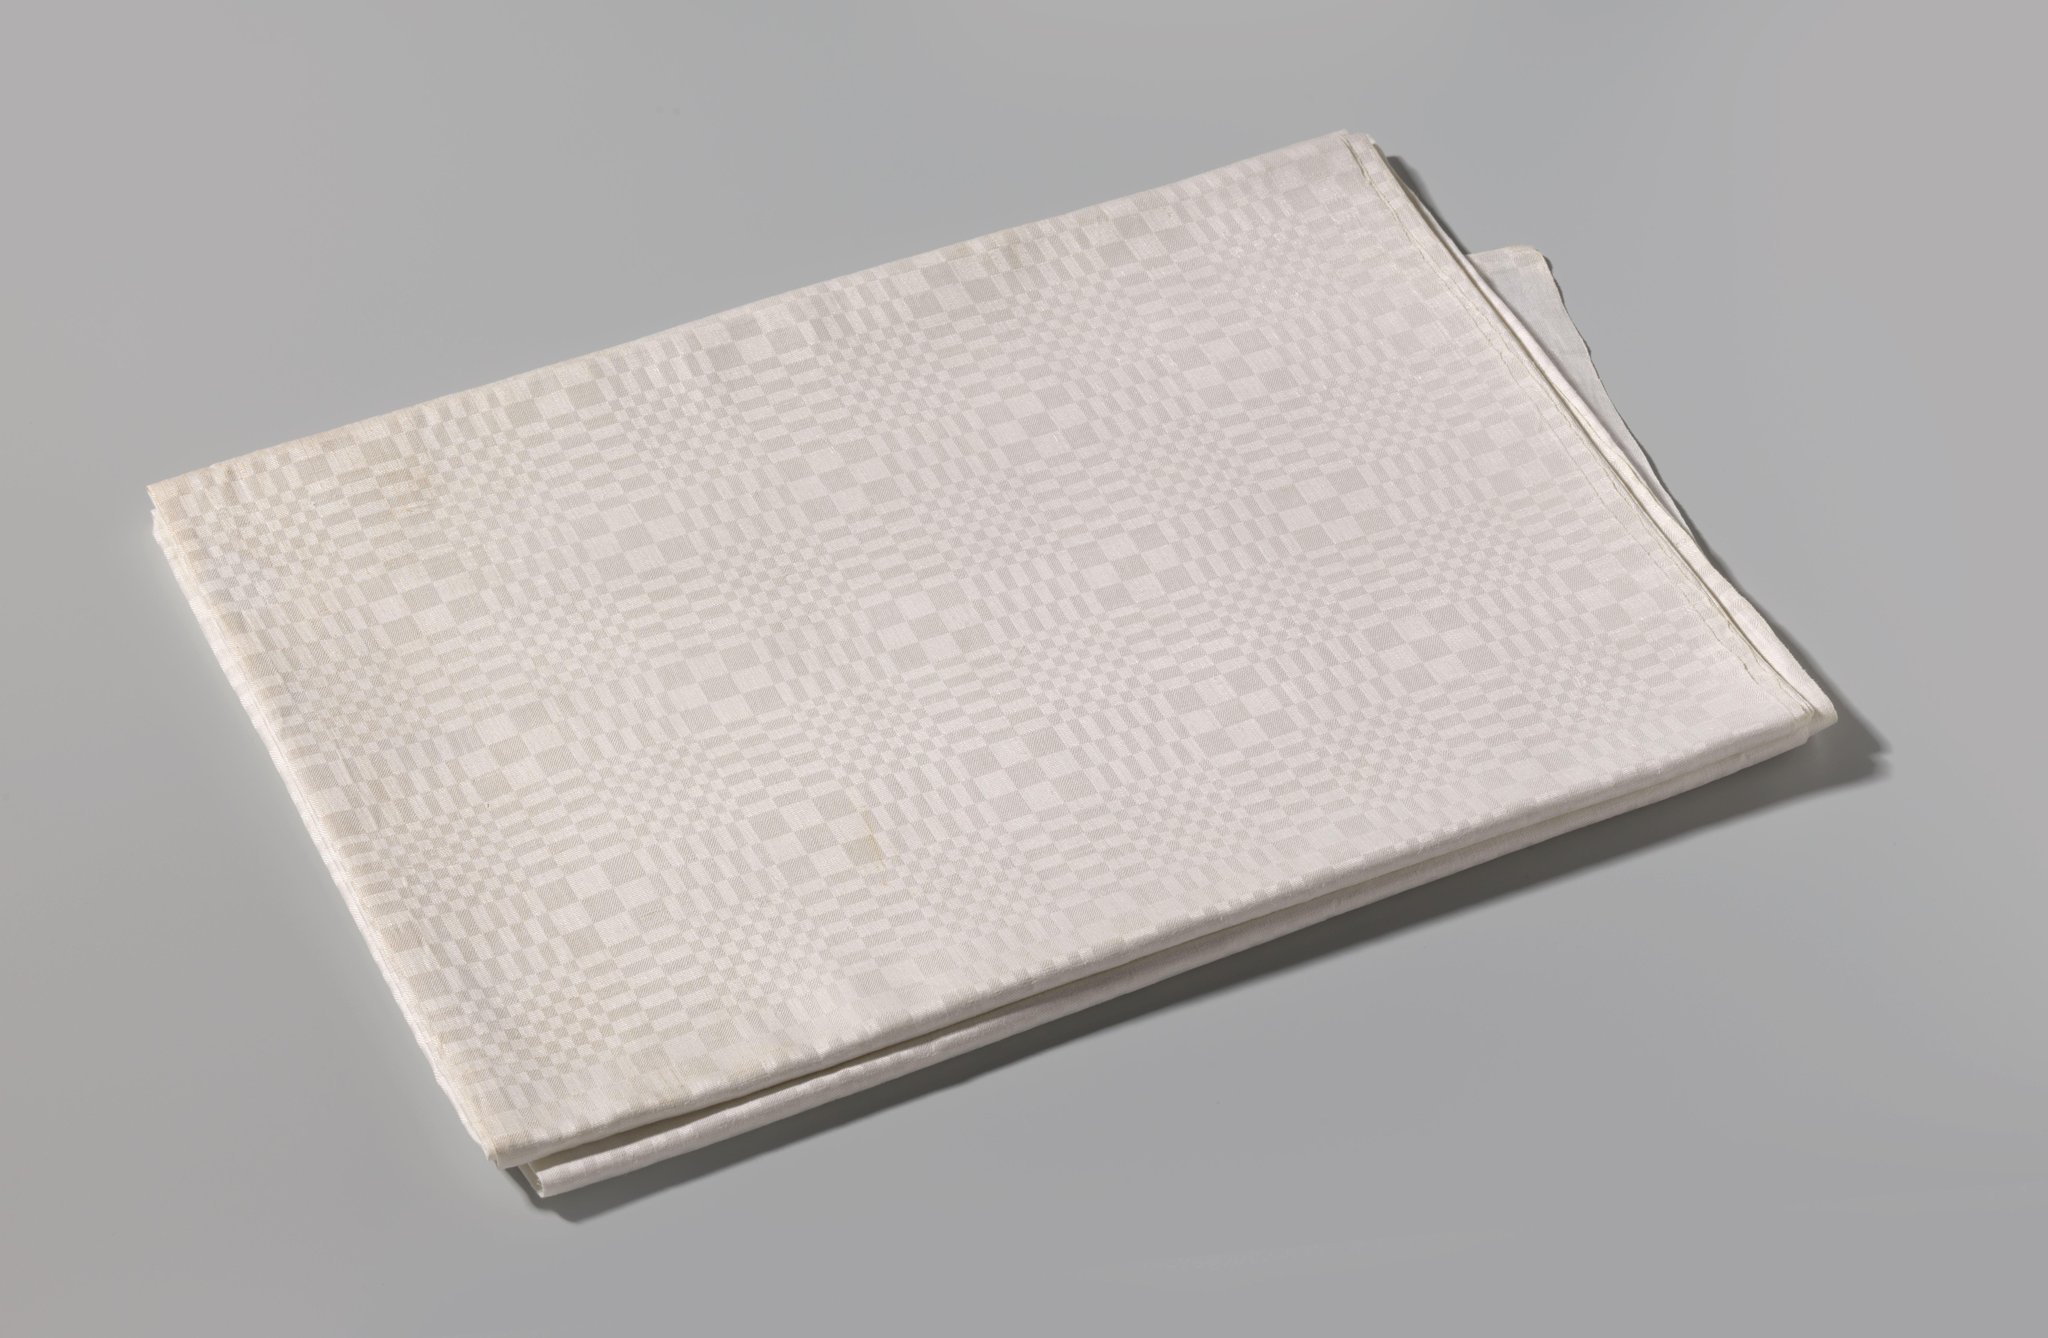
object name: tablecloth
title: Pellen, zogenaamde Engelse garderobe. Merk: WS en jaartal 1784.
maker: Anonymous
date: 1784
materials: linen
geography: northern netherlands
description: Tafellaken van wit linnen met pellen patroon, z.g. Engelse garderobe, merk WS en 1784